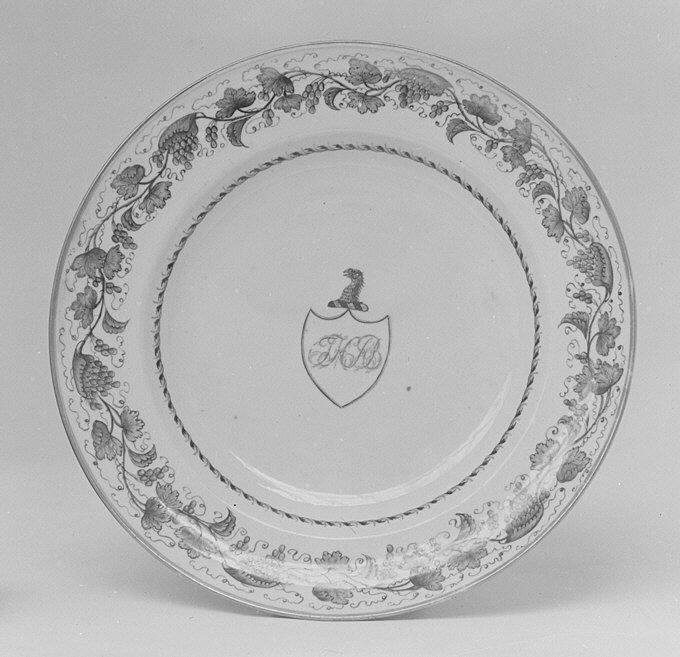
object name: soup dish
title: Soup dish (part of a service)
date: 1790-1800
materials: hard paste porcelain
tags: grapes,insignia